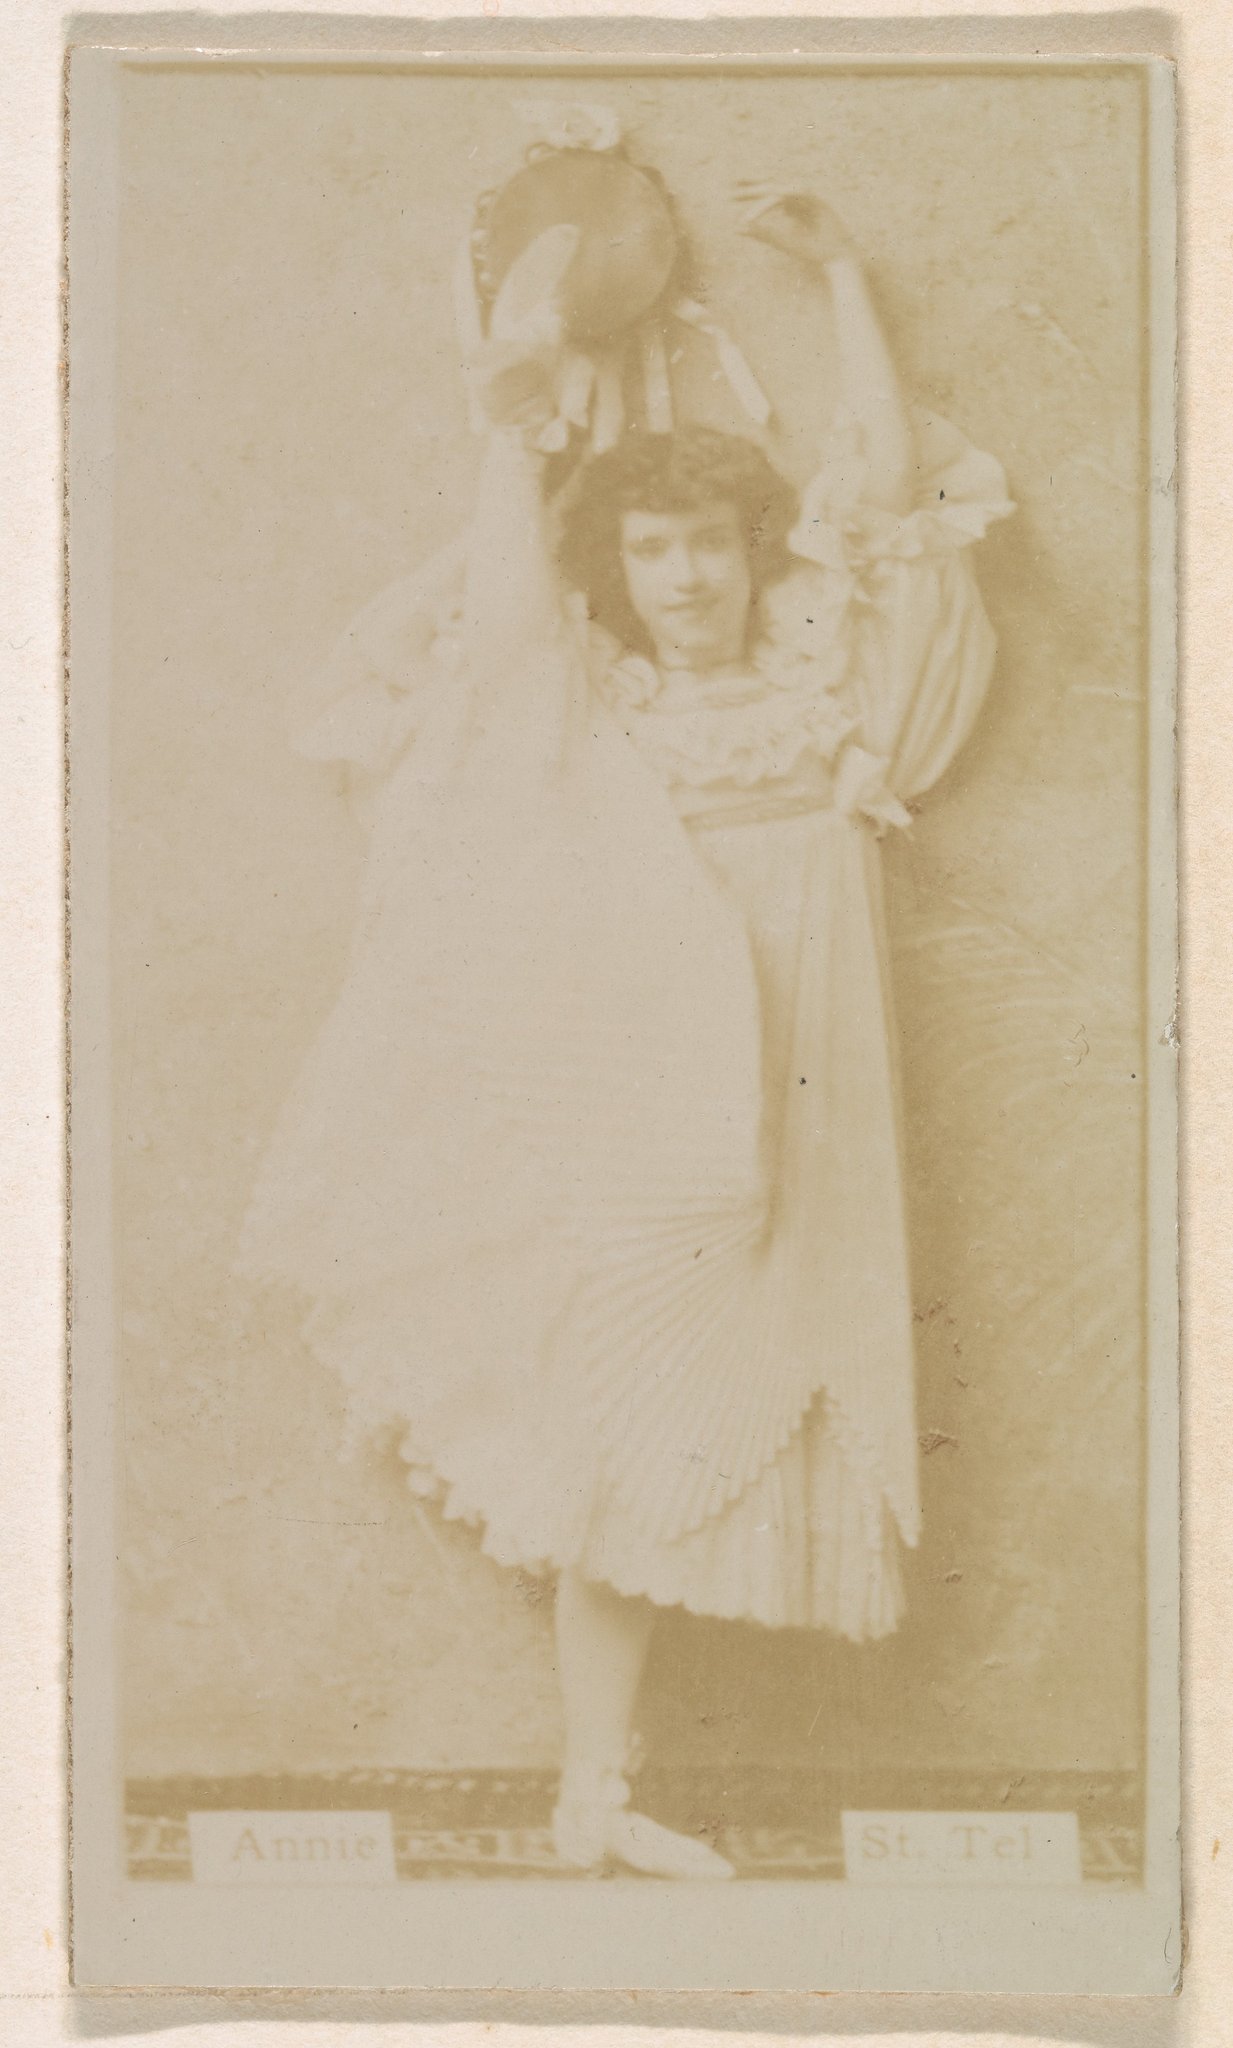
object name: photograph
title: Annie St. Tel, from the Actresses series (N245) issued by Kinney Brothers to promote Sweet Caporal Cigarettes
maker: kinney brothers tobacco company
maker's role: publisher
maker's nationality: american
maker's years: 1869-2011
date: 1890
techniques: albumen silver print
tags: portraits,women,actresses